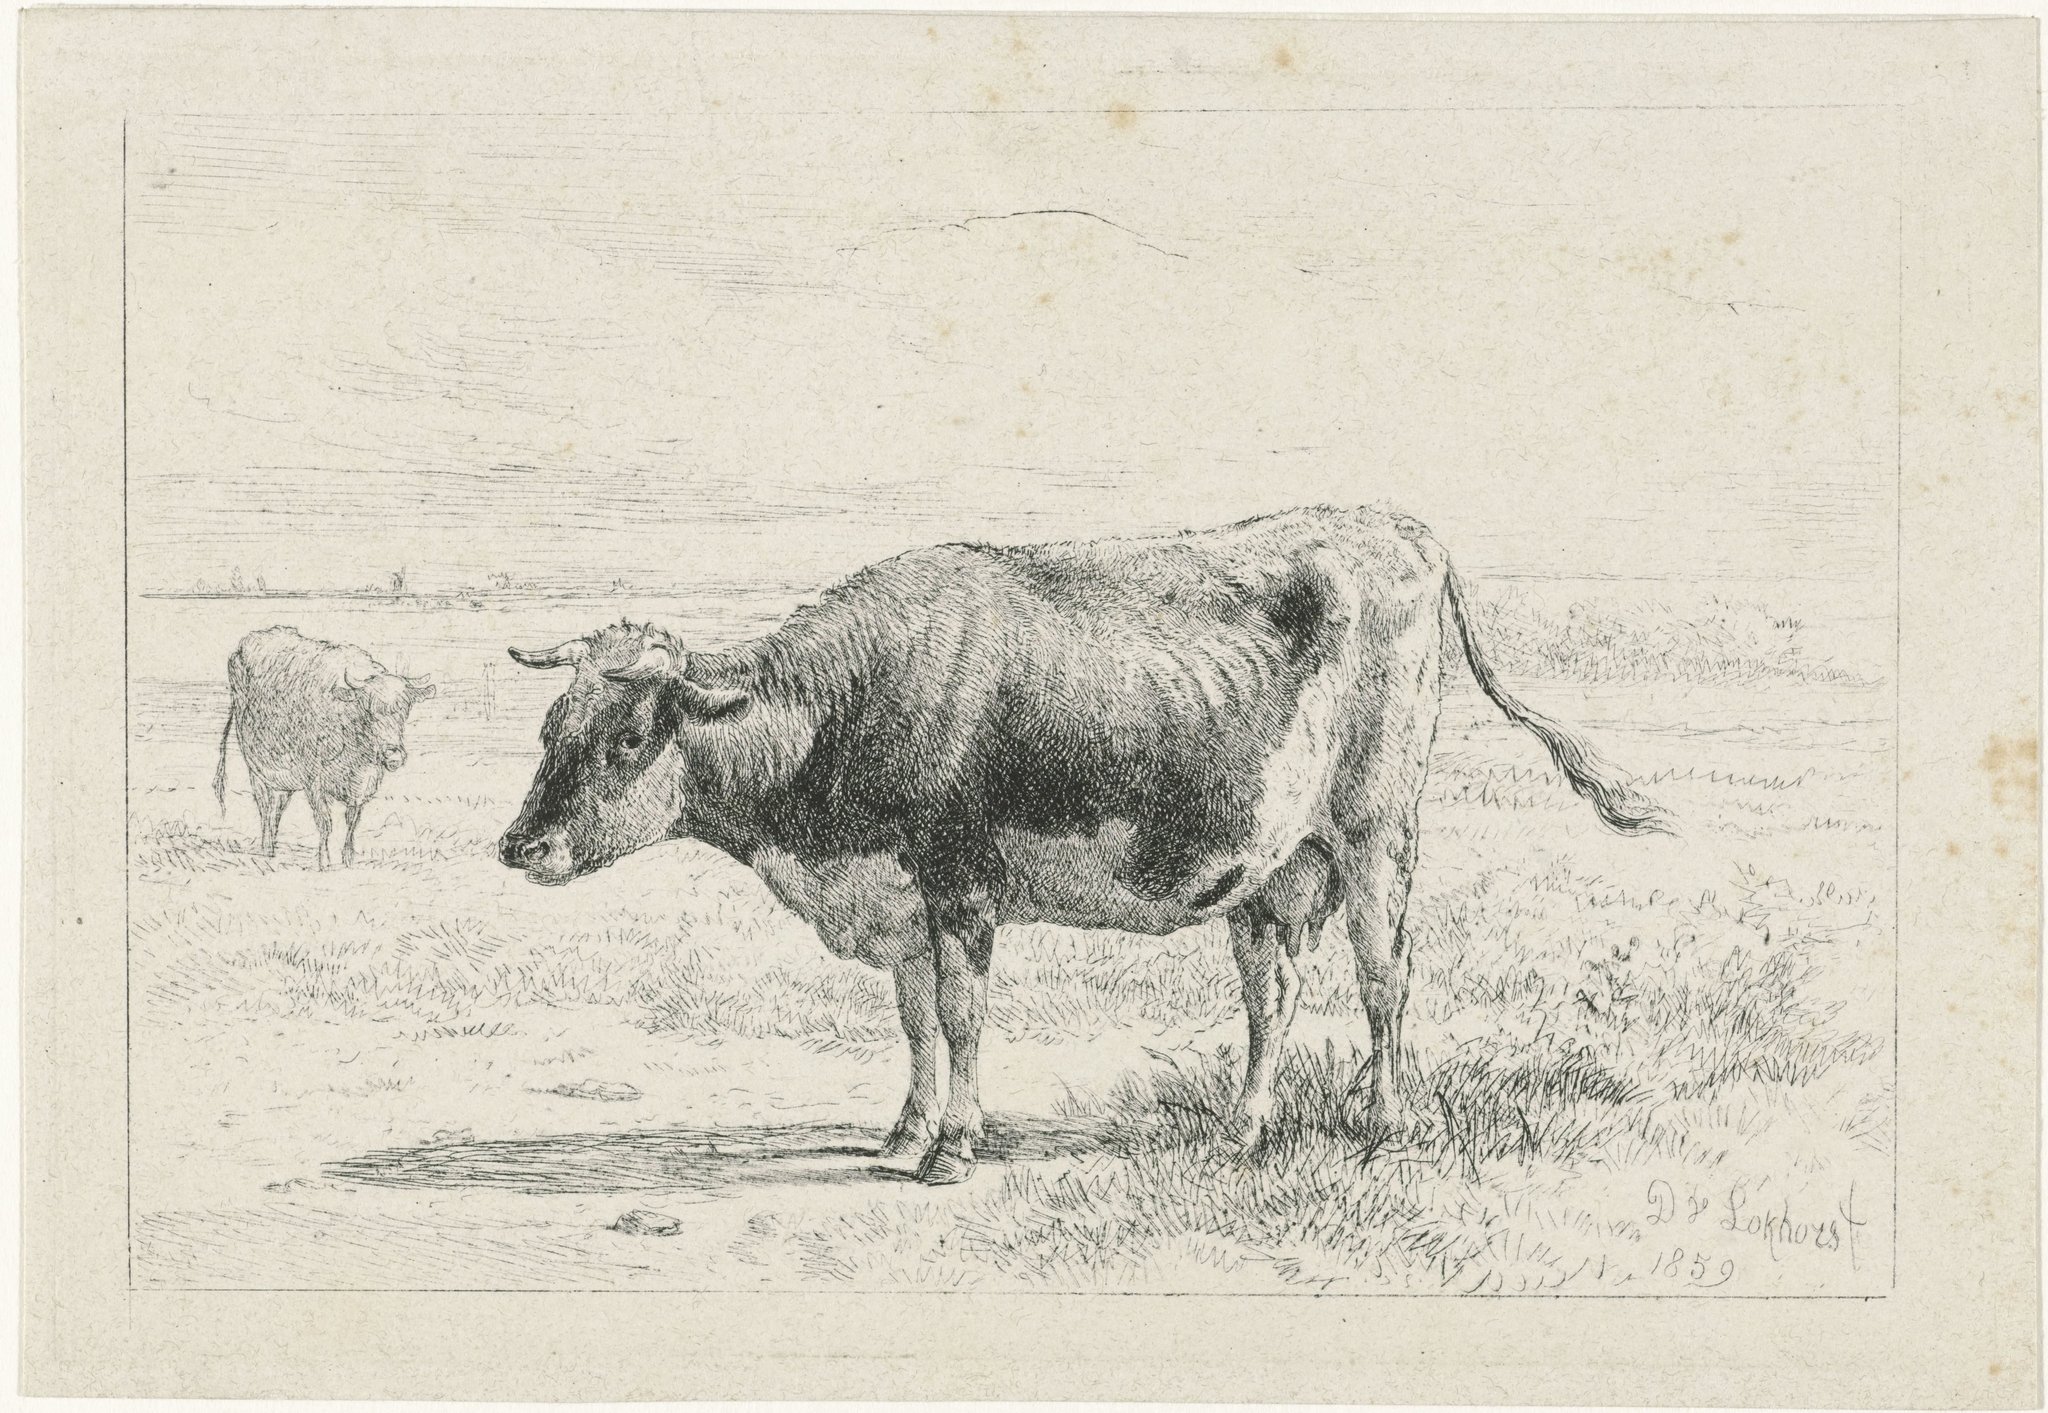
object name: print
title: Twee koeien in een weide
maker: dirk van lokhorst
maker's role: draughtsman, painter, print maker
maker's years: 1818-1893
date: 1859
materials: paper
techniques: etching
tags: cow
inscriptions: collector's mark: Lugt 2228